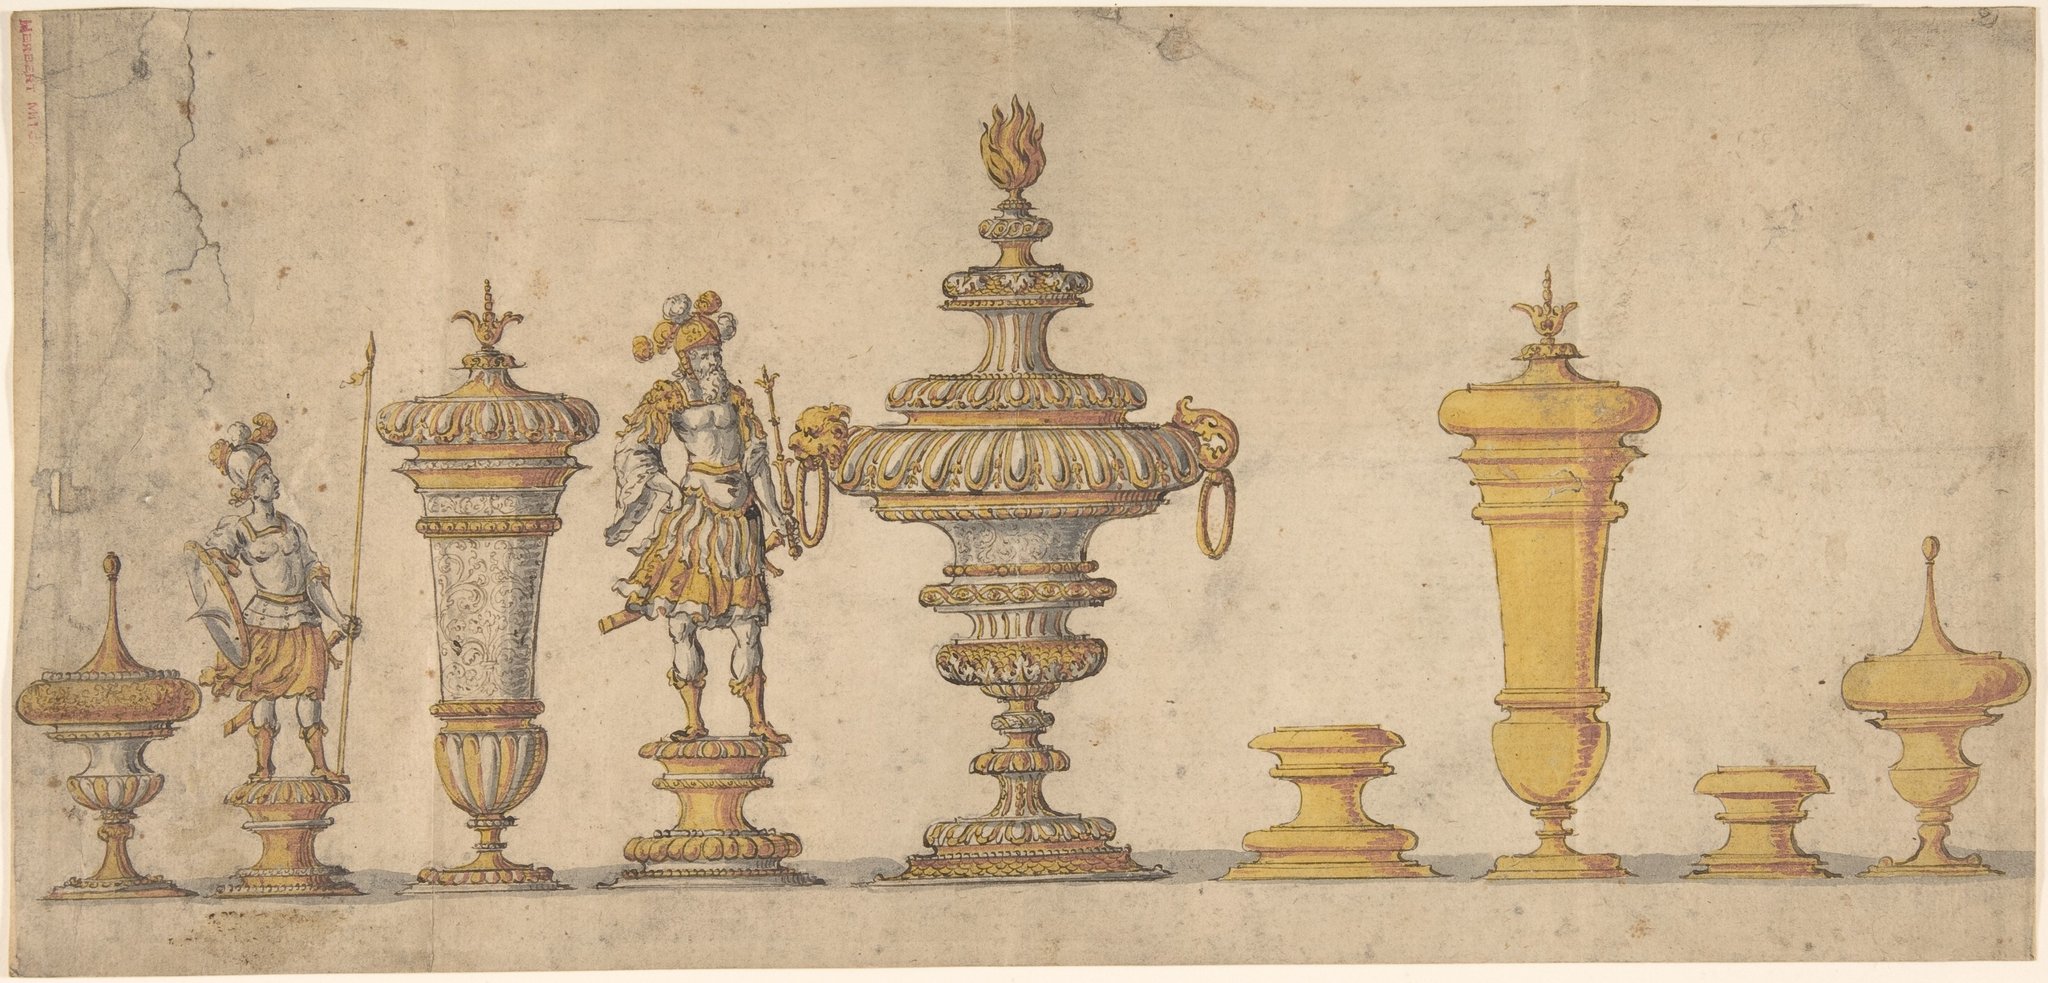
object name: collection ornament architecture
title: Studies for Decorative Arts Objects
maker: anonymous, german, 17th century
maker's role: artist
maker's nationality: german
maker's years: 1600-1700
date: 1601-1700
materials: ink, watercolor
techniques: pen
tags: men,vessels